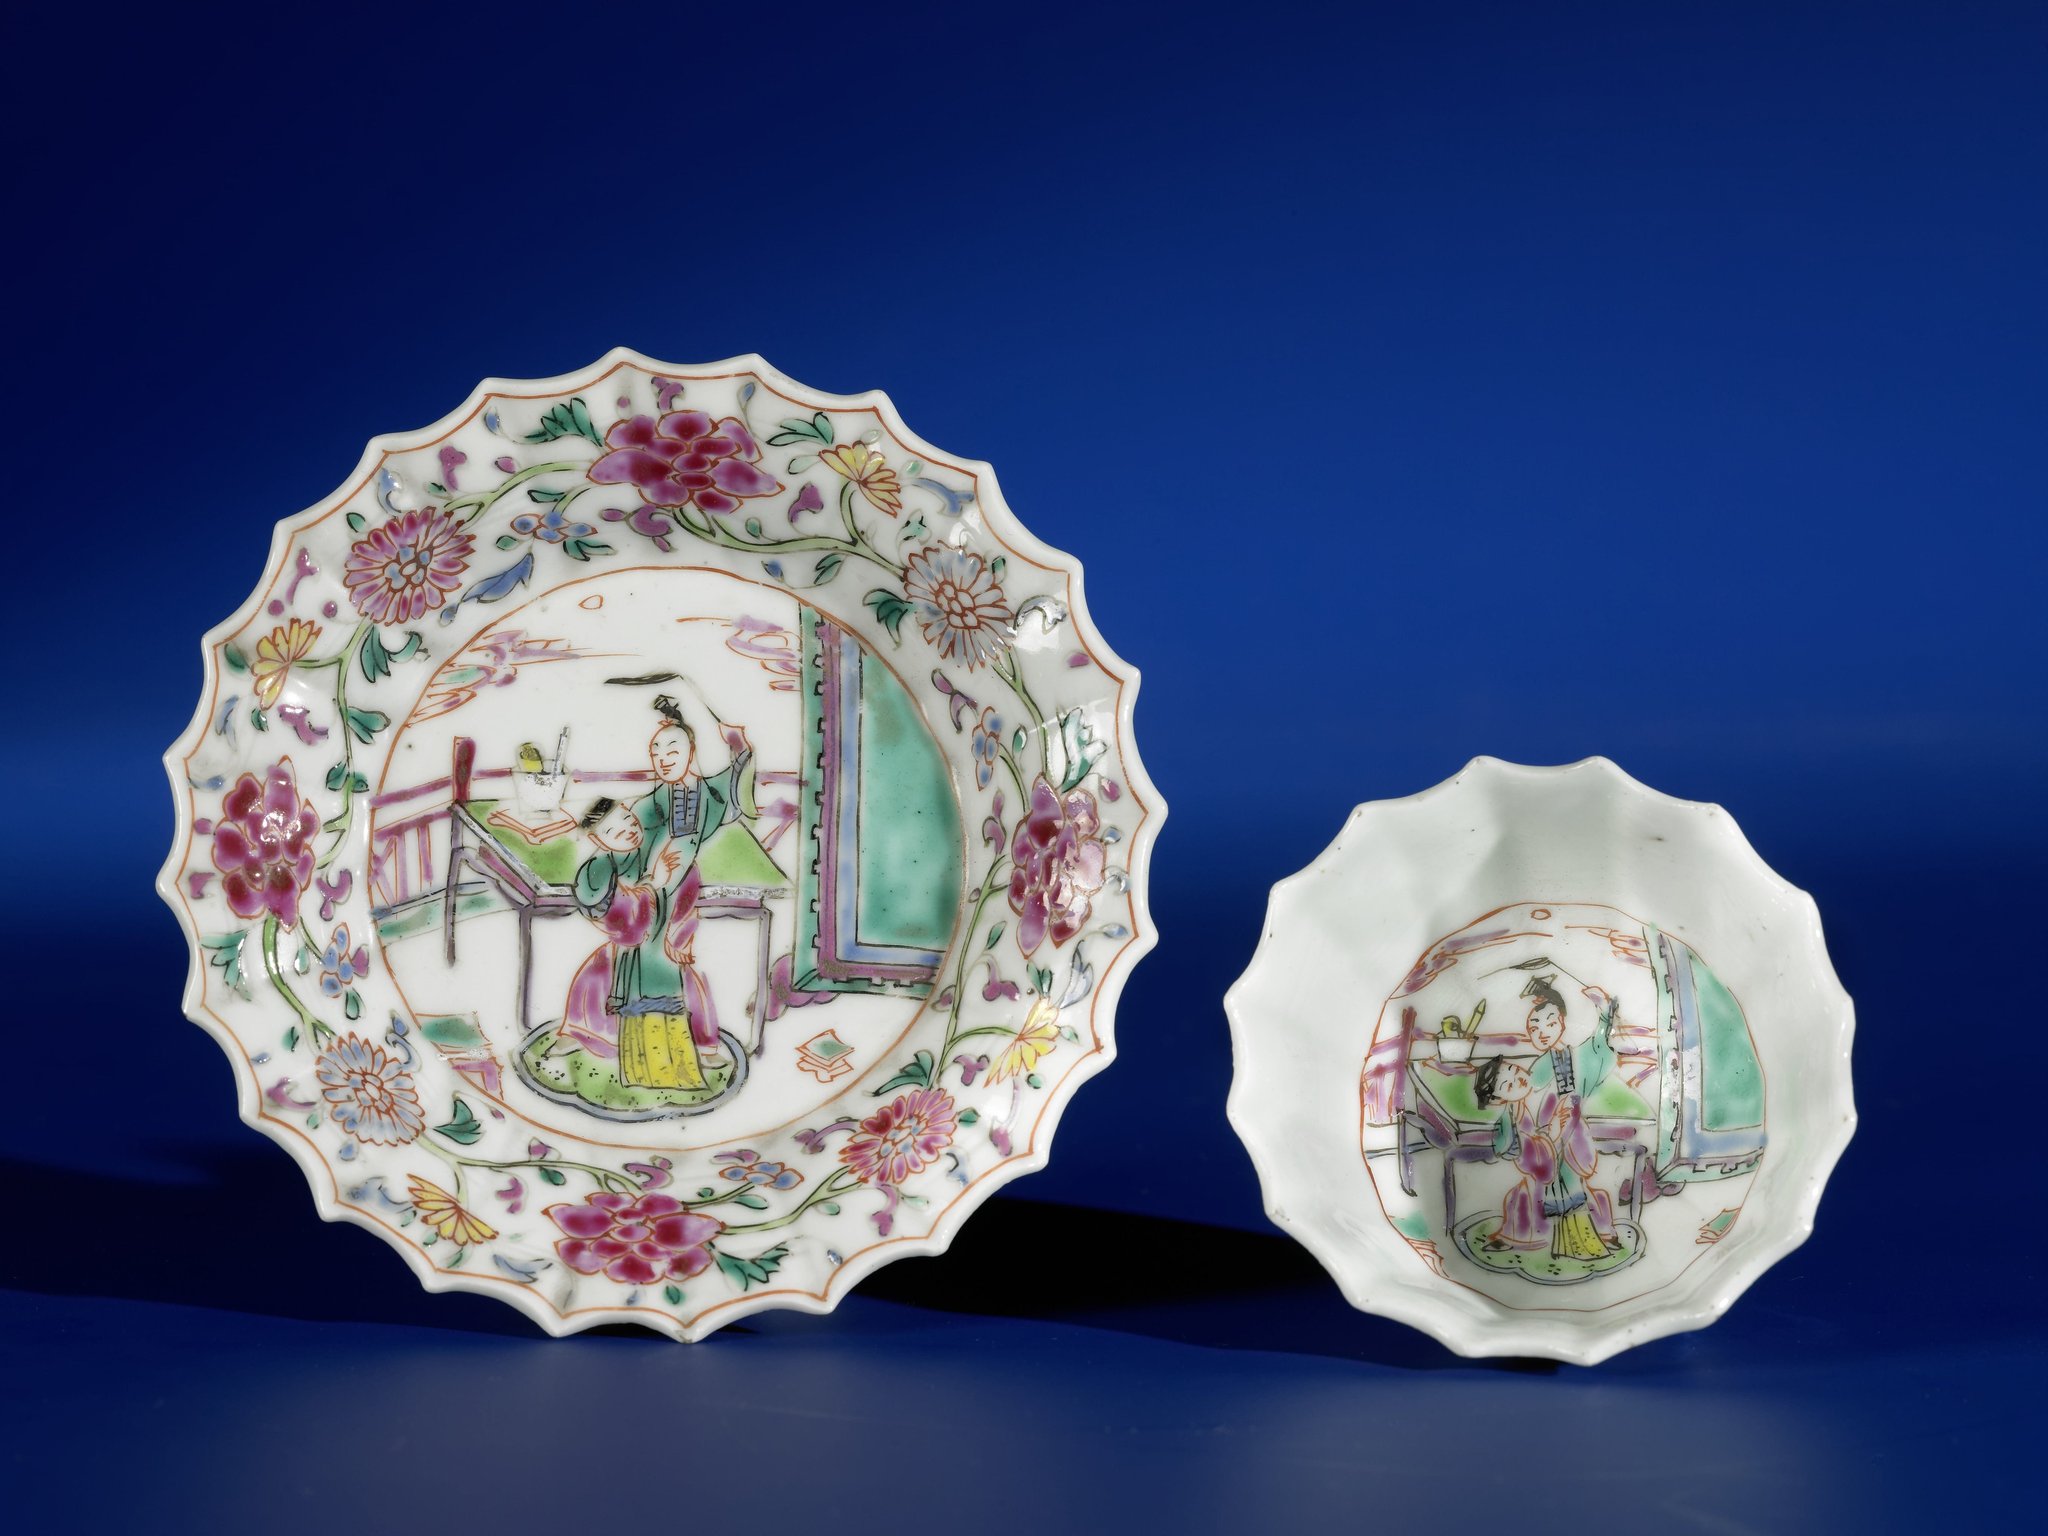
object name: kop en schotel, kop en schotel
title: Bell-shaped cup and saucer with a man and woman on a terrace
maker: Anonymous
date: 1725-1749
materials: glaze, gold, paint, porcelain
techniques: firing, gilding, turning, vitrification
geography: china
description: Kop en schotel met een licht geribde wand en een gekartelde rand. Beschilderd in emailkleuren met een doorlopend motief van bloeiende planten op de wand. In het plat wordt een Chinese vrouw omarmd door een knielende man.